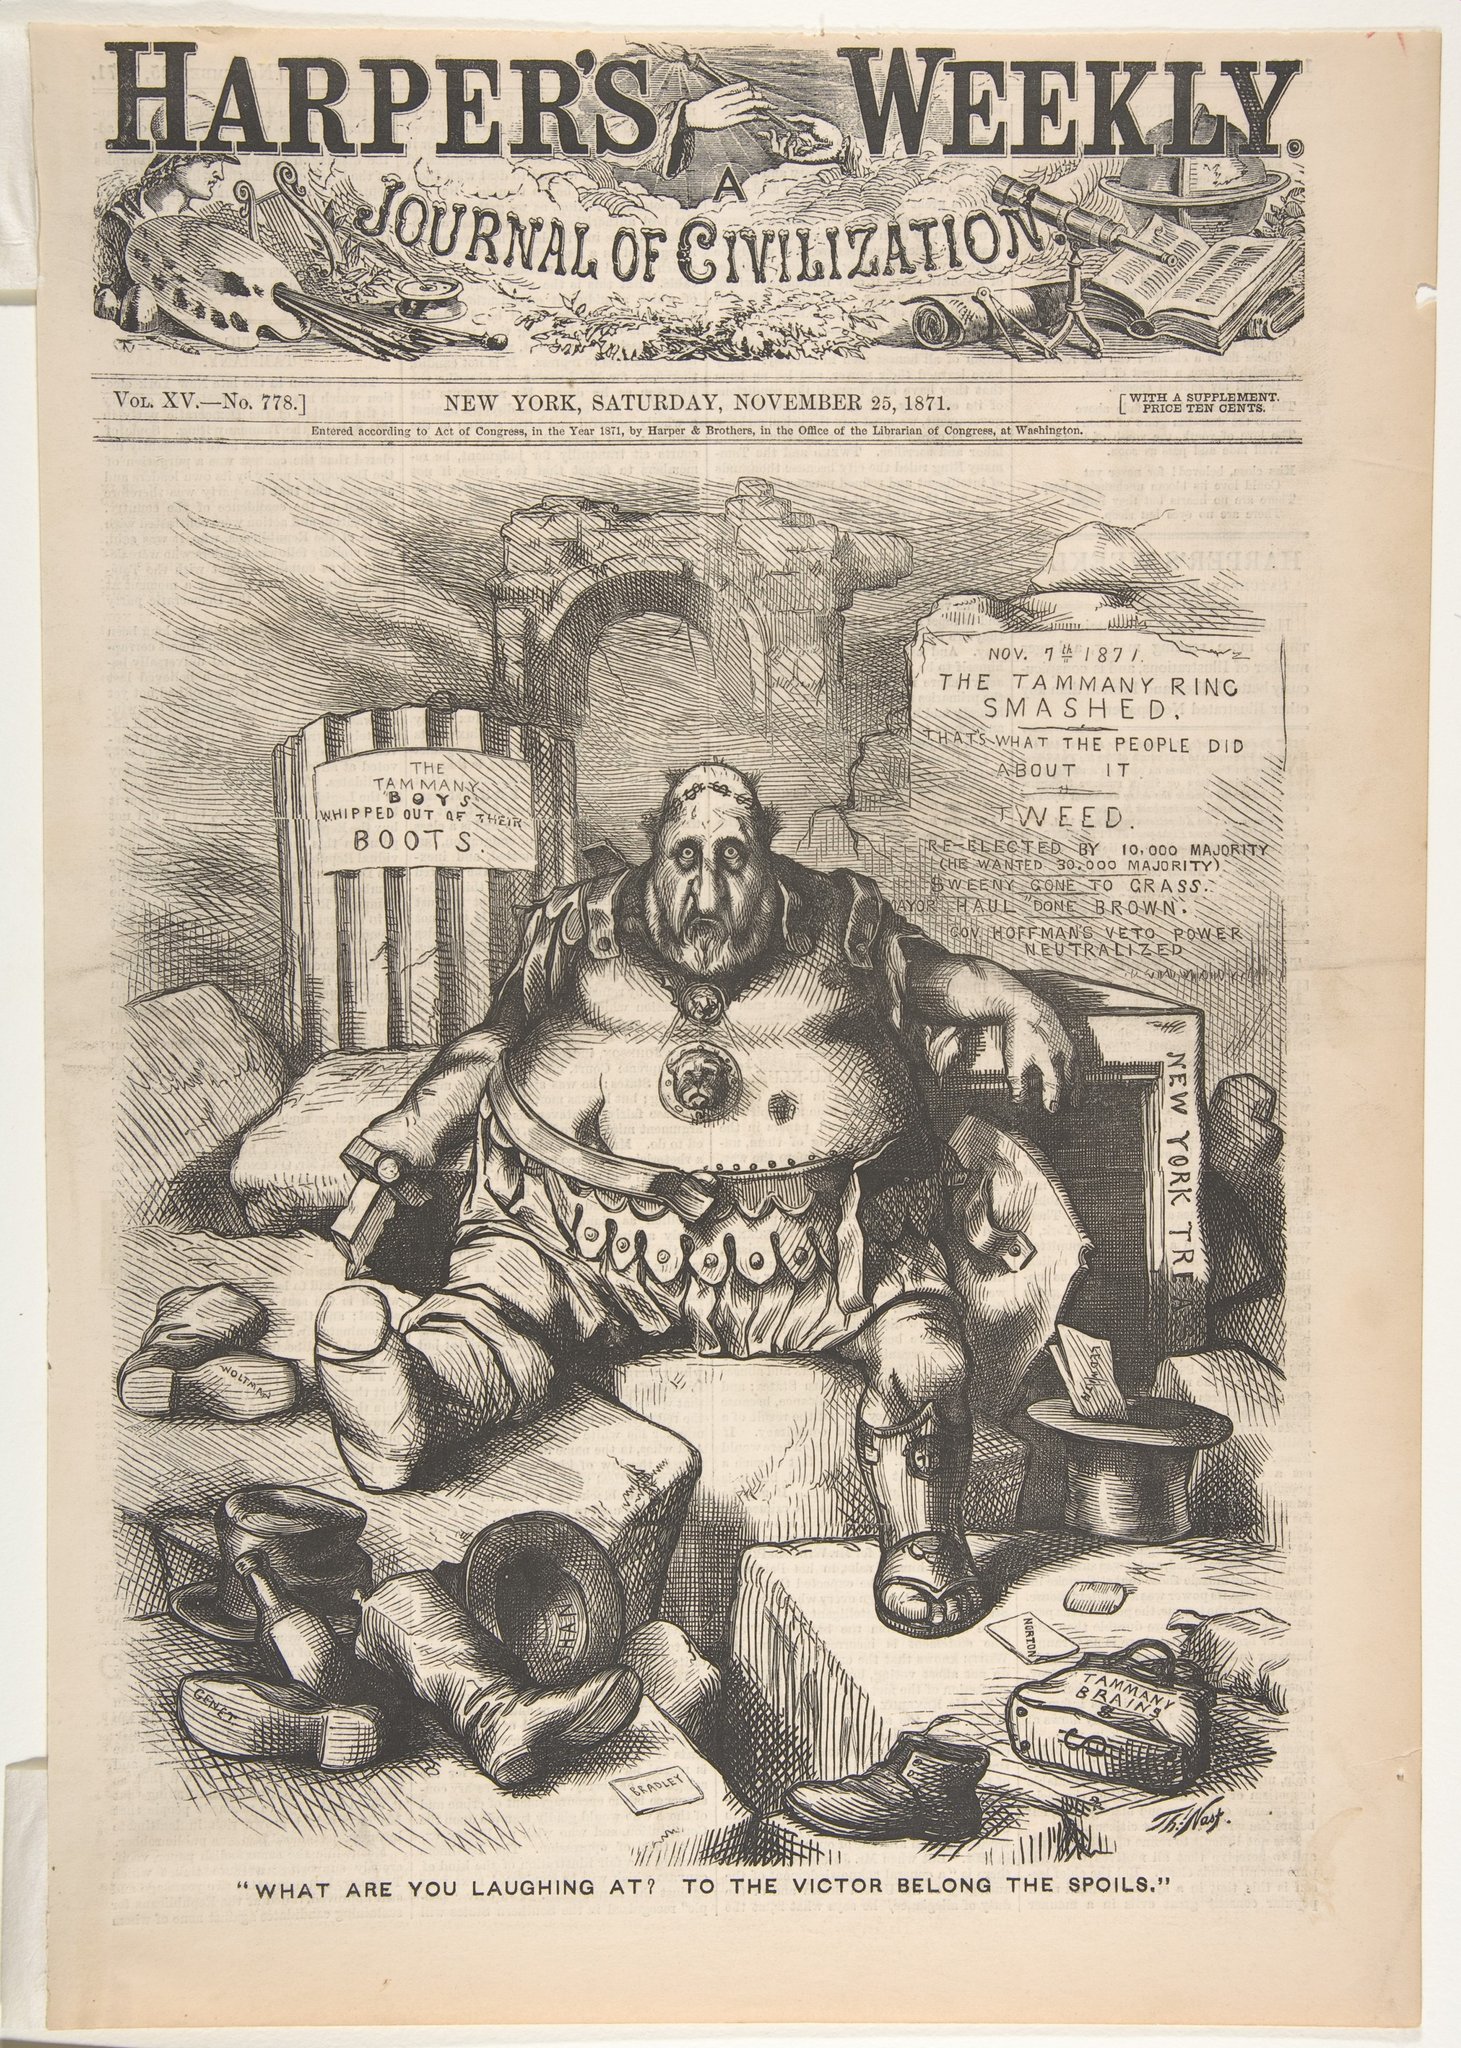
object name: print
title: "What Are You Laughing At? To the Victor Belong the Spoils" (from "Harper's Weekly," vol. 15, p. 1097)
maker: thomas nast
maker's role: artist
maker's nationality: american, born germany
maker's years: 1840-1902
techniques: engraving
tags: caricature,politics